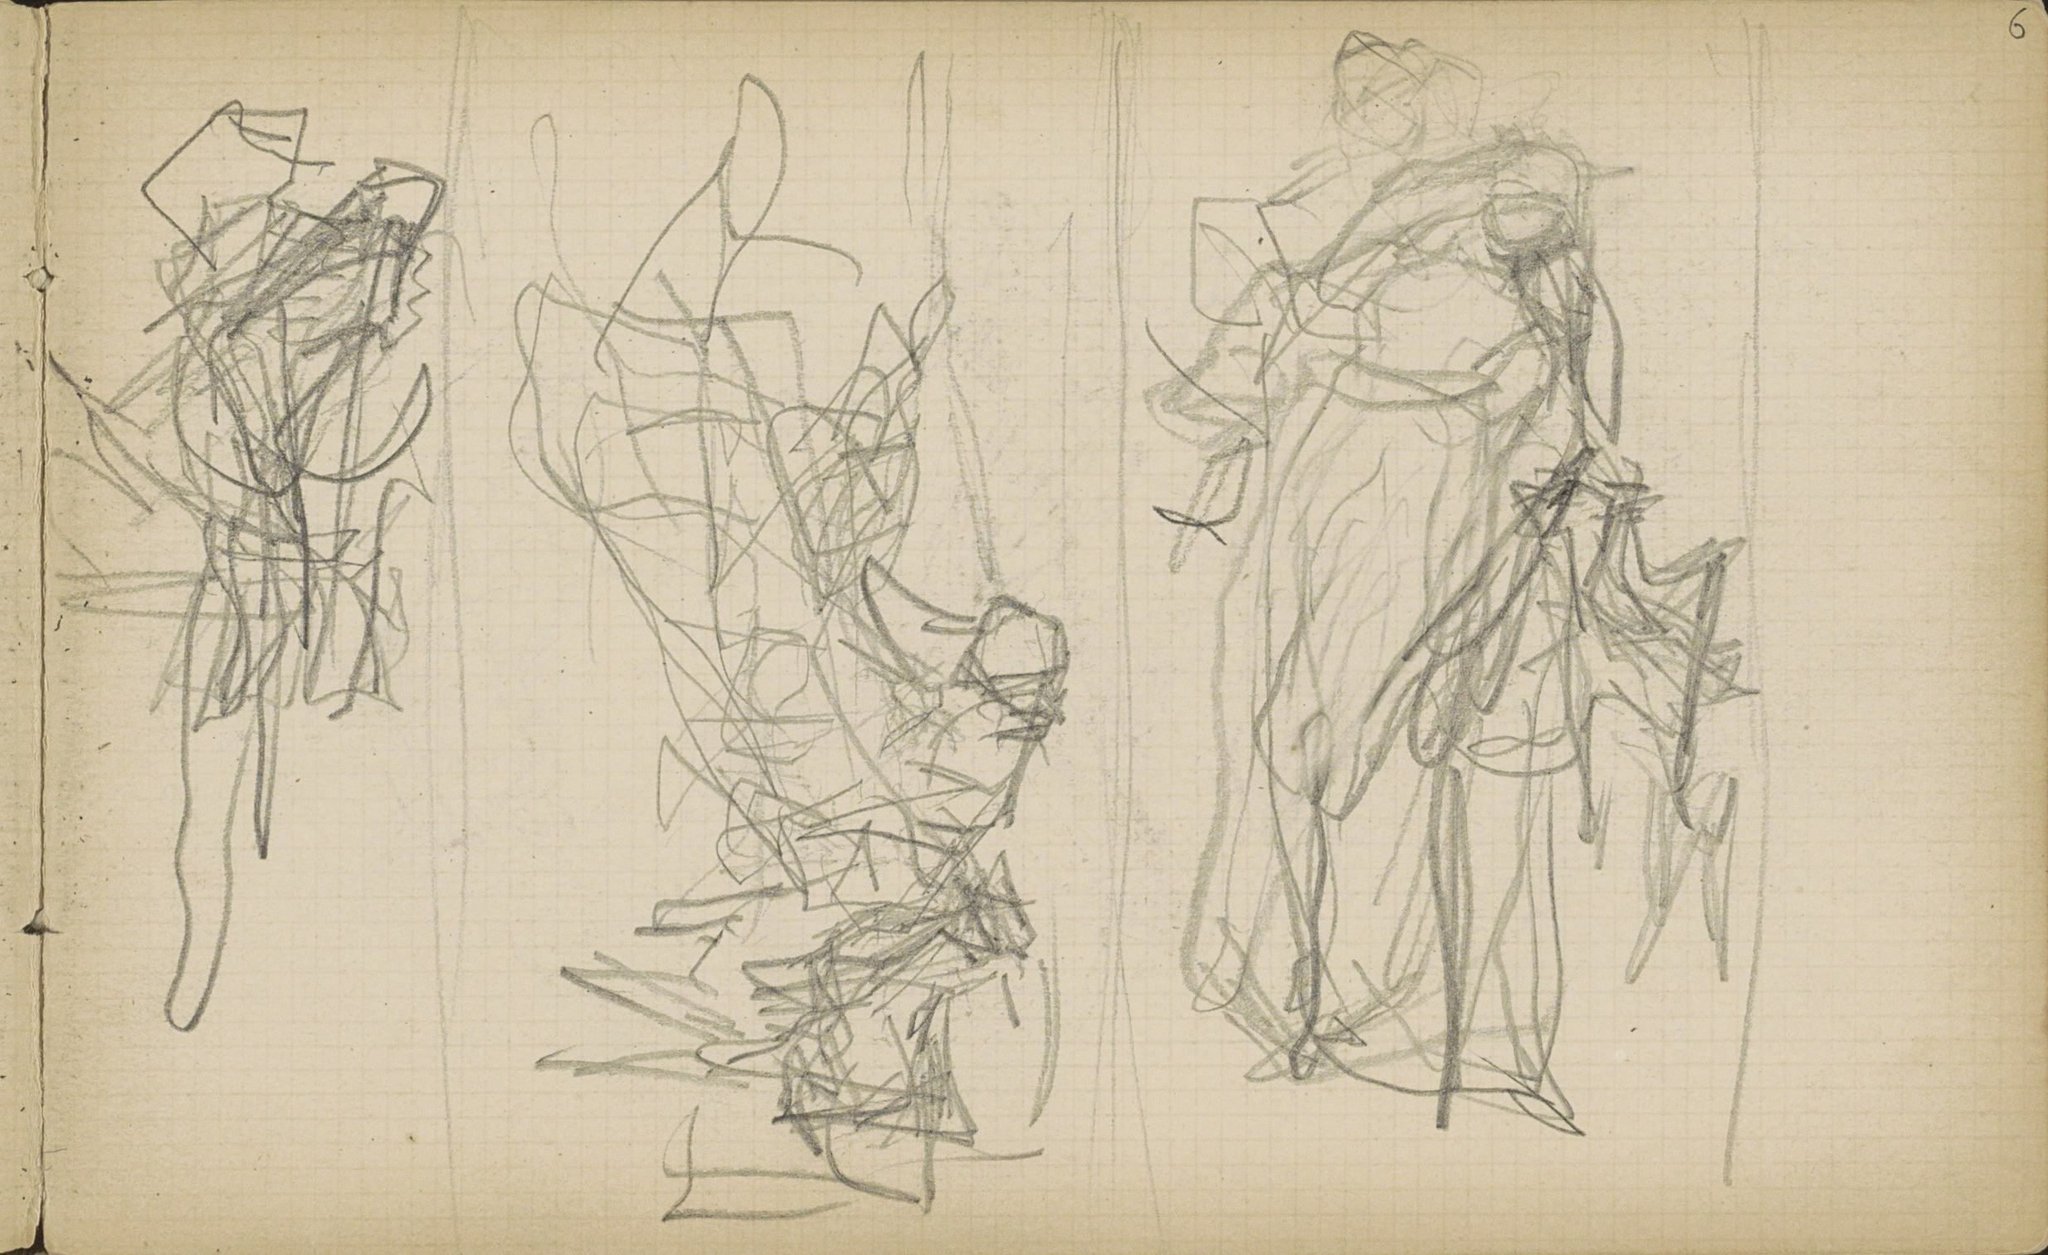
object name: sketchbook leaf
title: Studieblad, onder andere met een staande vrouw in een lang gewaad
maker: matthijs maris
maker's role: draughtsman, painter, print maker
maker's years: 1839-1917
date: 1849-1917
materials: pencil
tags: standing figure (+ female (human being) (not to be used where -aa- is prescribed)), clothes, costume (+ women's clothes)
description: Blad 6 recto uit een schetsboek met 35 bladen.